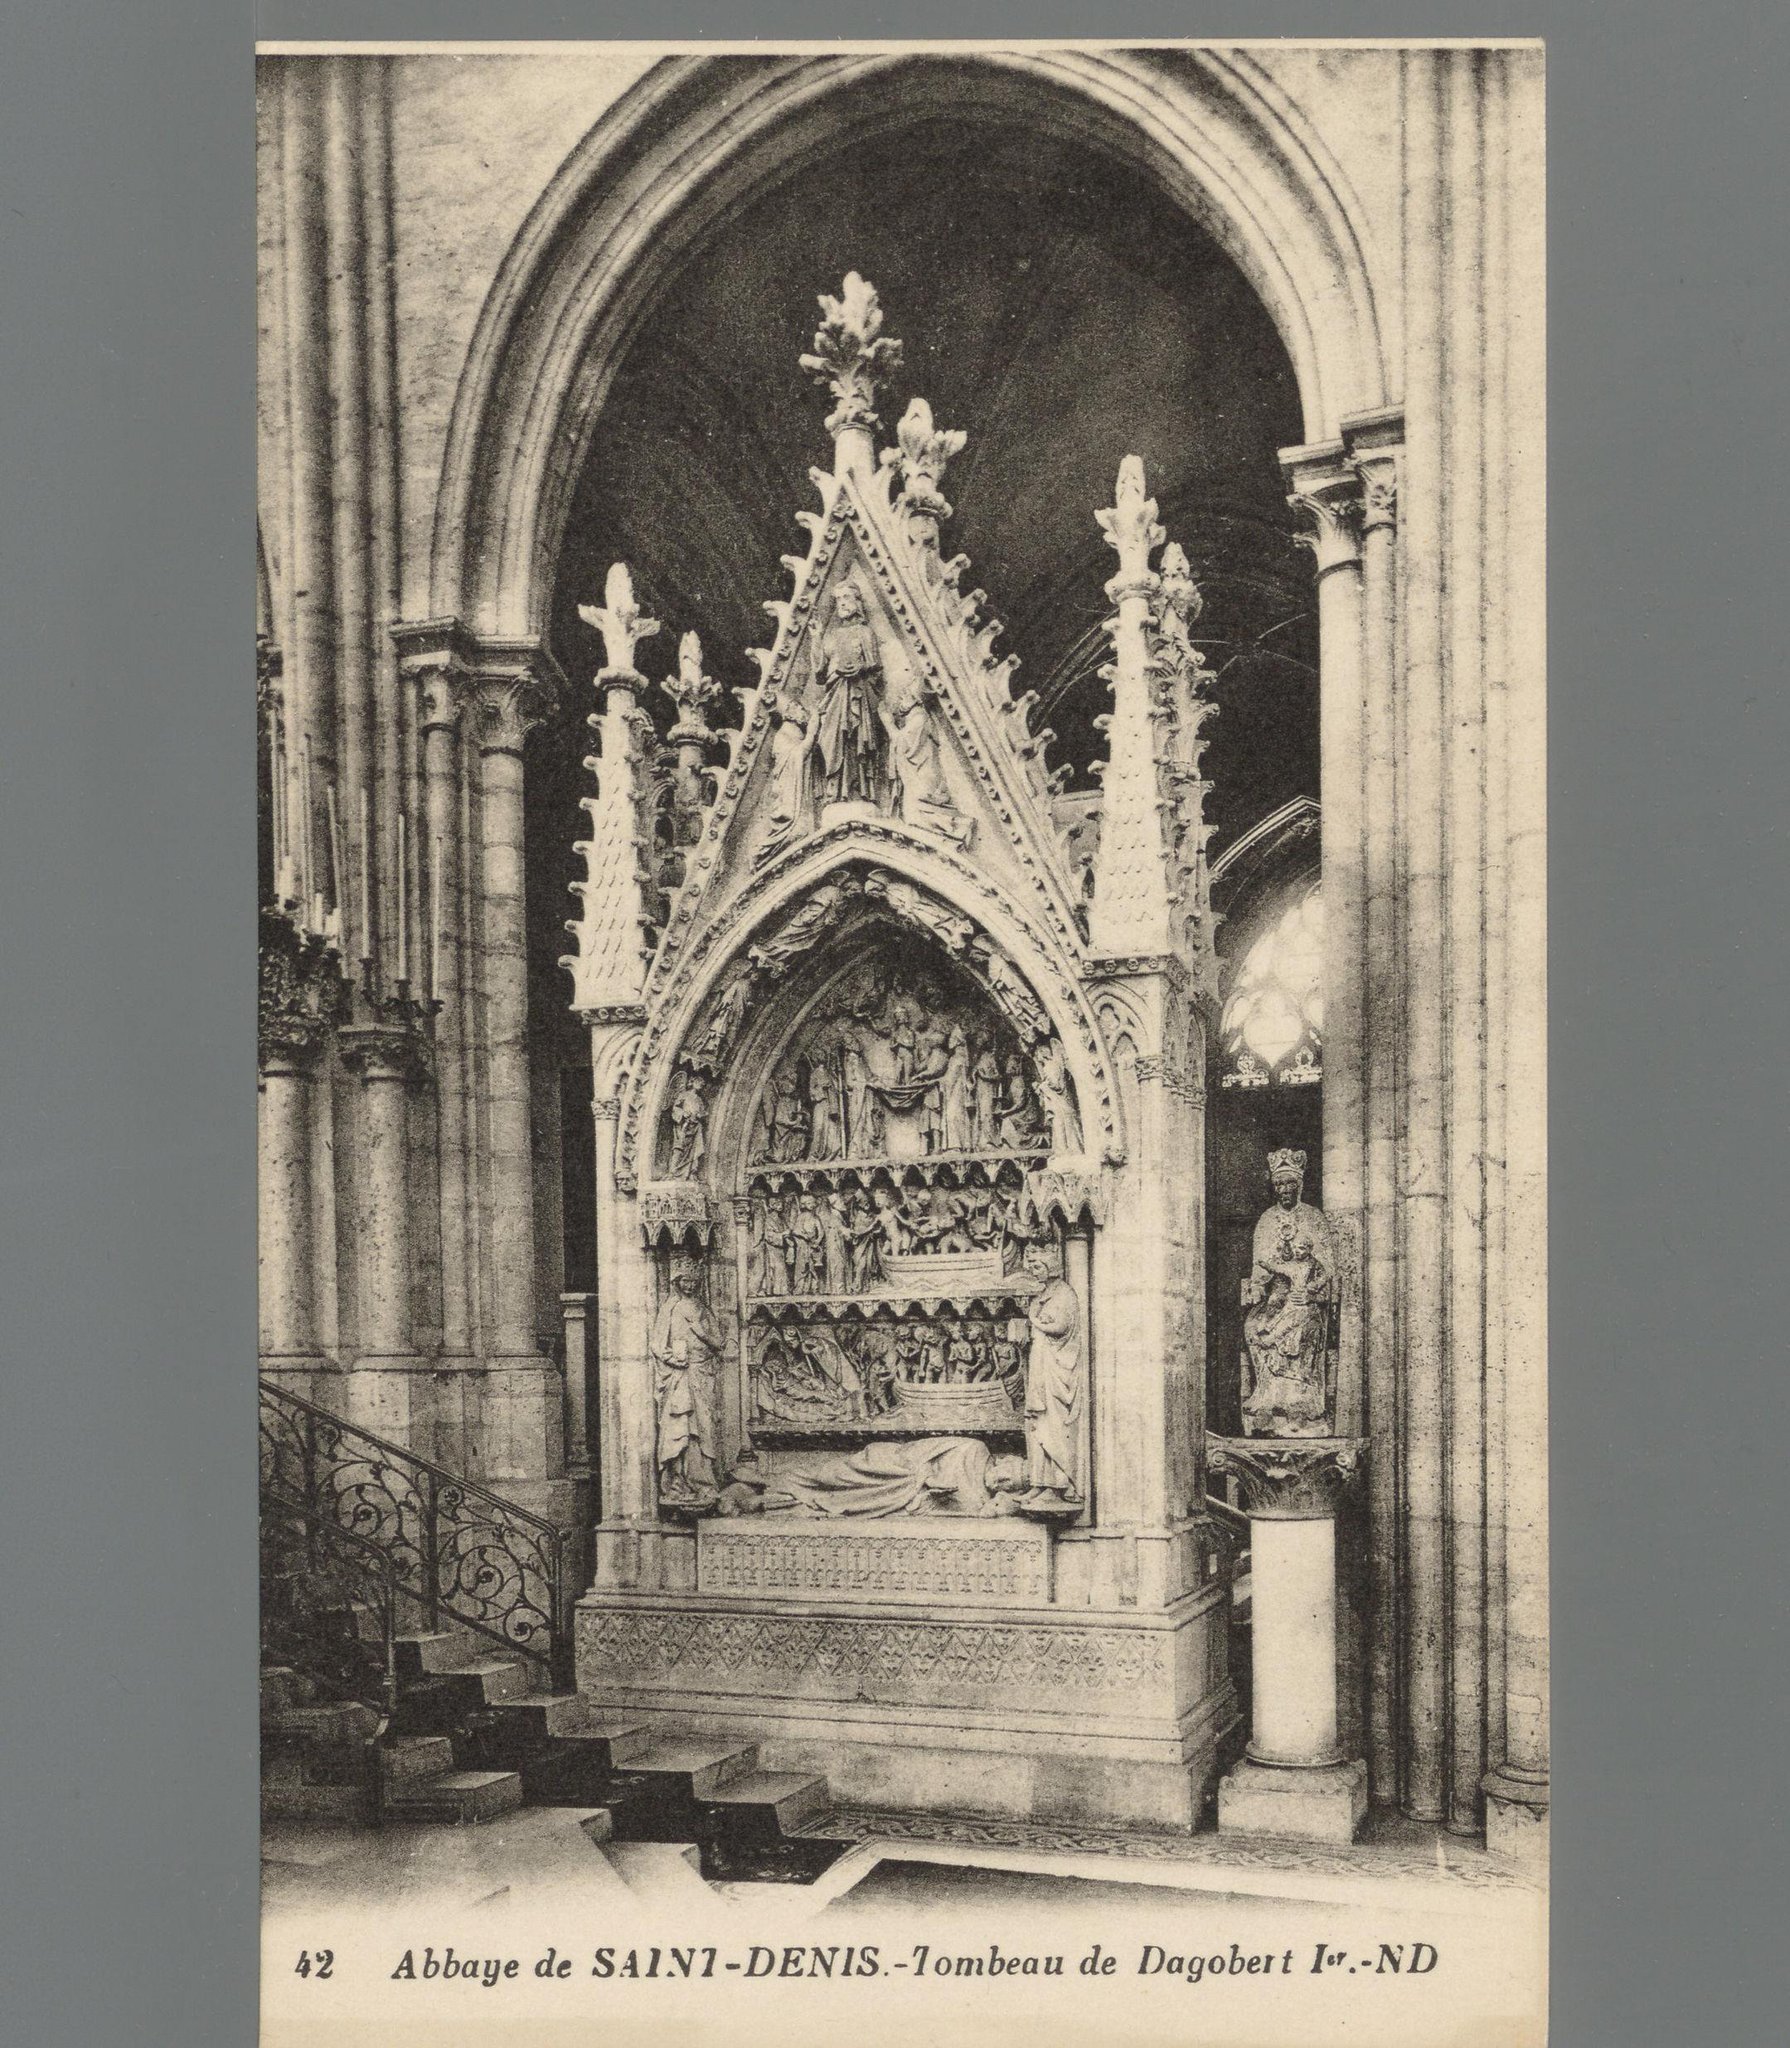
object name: photomechanical print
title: Abbaye de Saint-Denis - Tombeau de Dagobert Ier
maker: Anonymous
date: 1903-1932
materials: cardboard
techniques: photograph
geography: reims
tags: abbey, monastery, convent ~ roman catholic church, grave, tomb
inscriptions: collector's mark: ‘AFE v S’